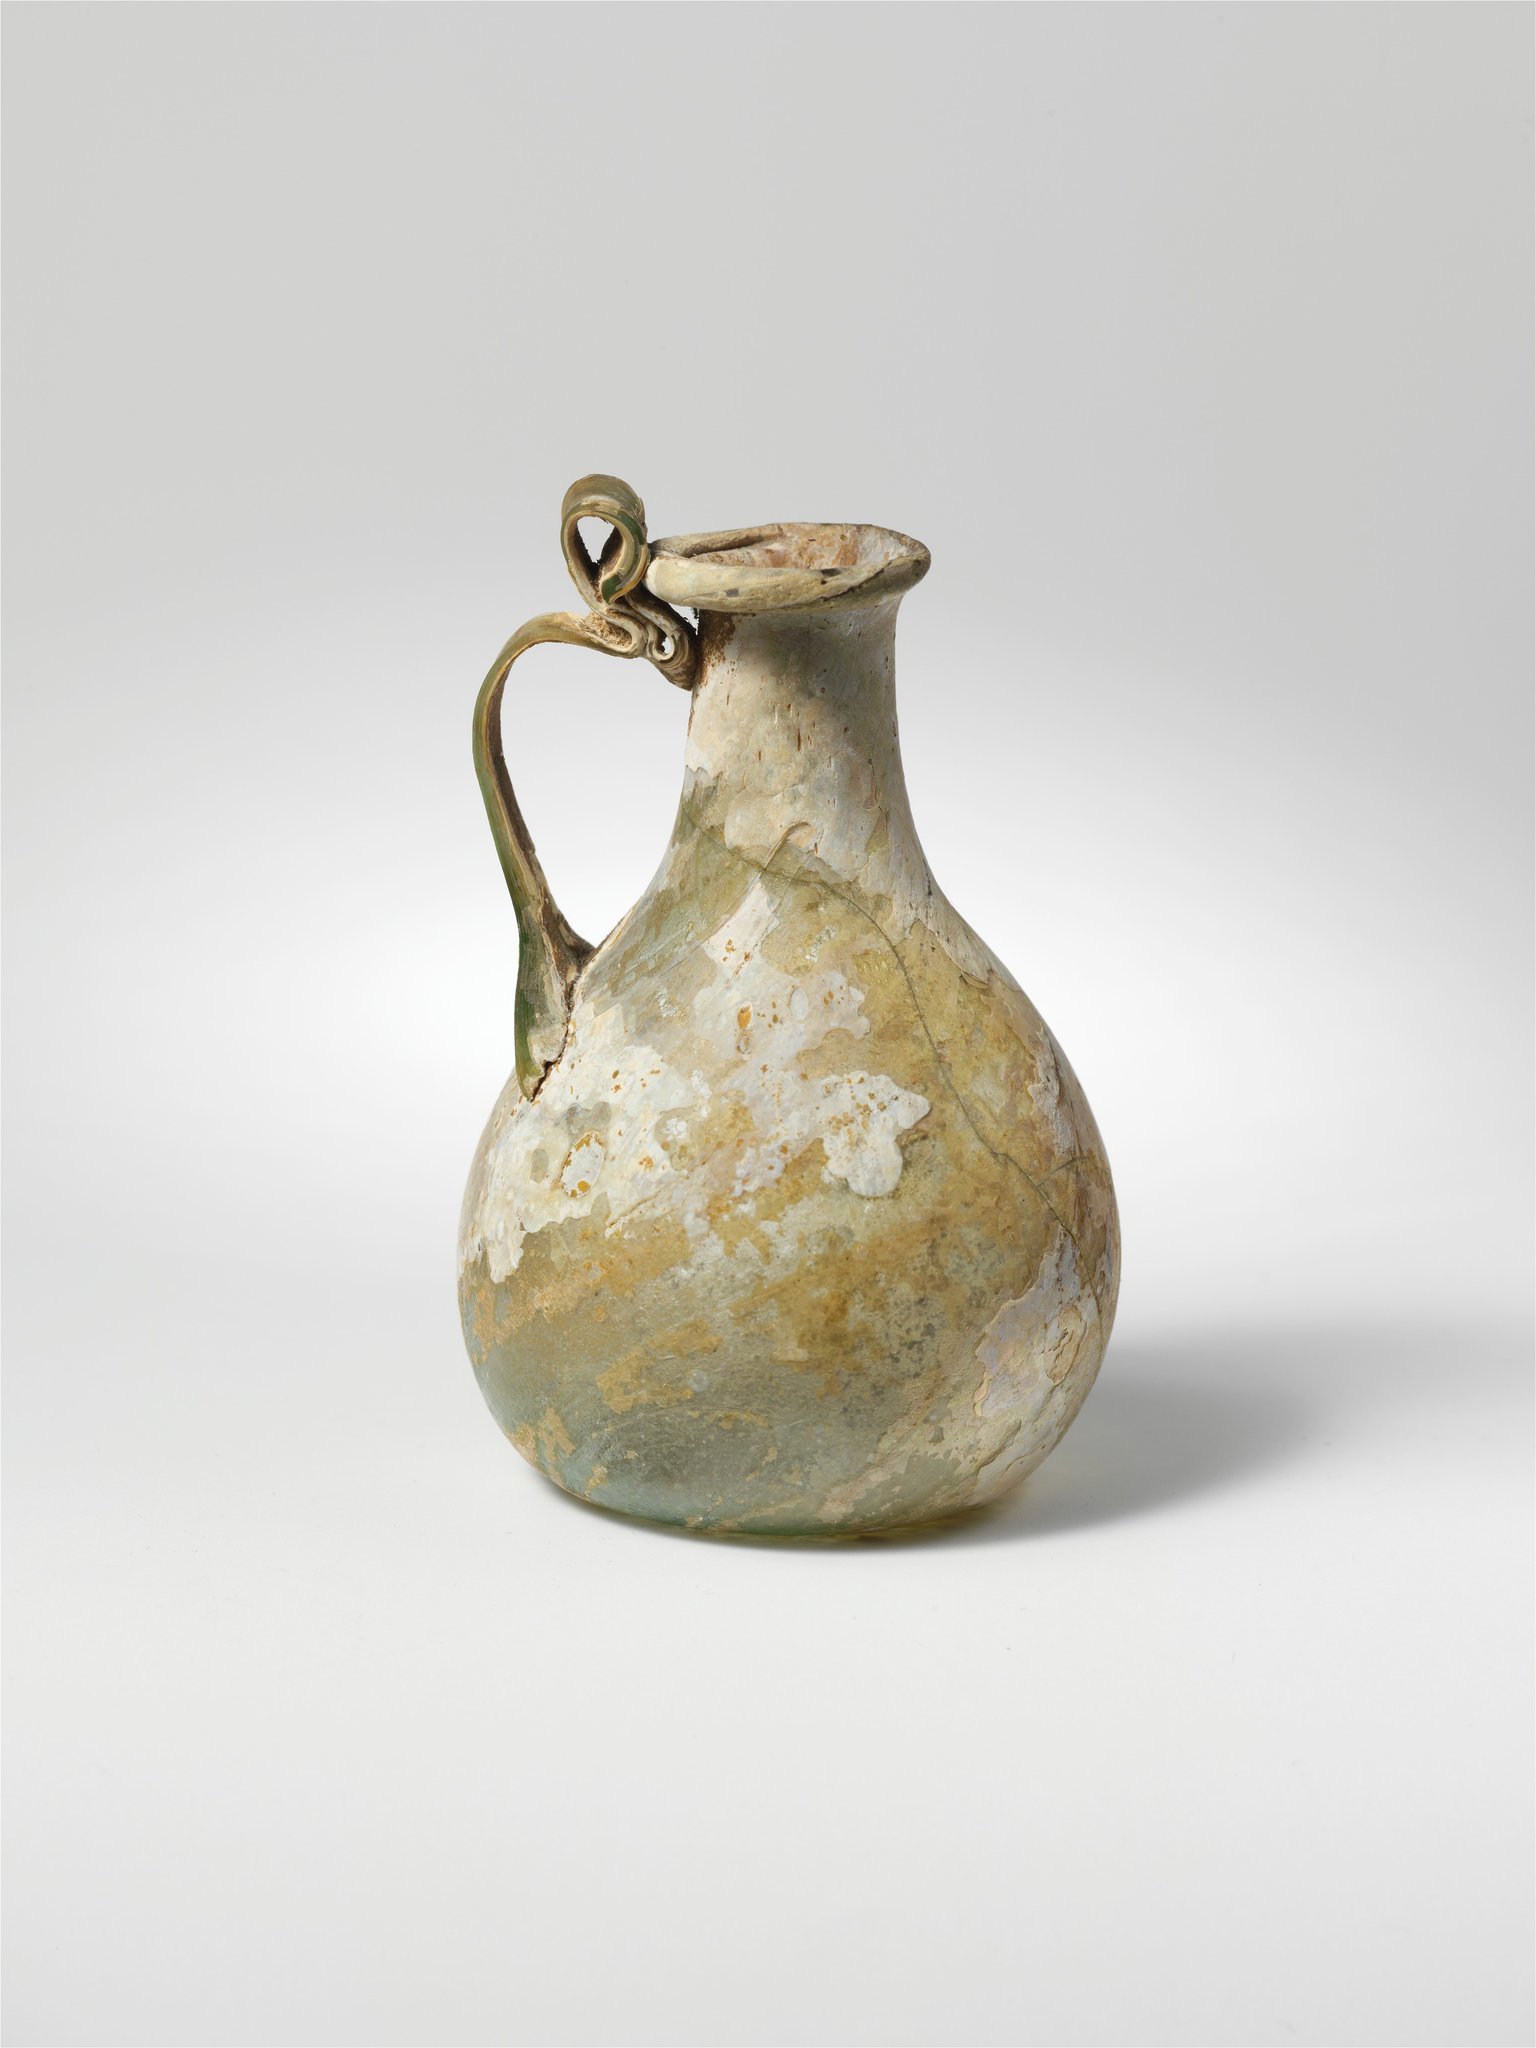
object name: jug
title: Glass jug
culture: roman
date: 1-300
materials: glass